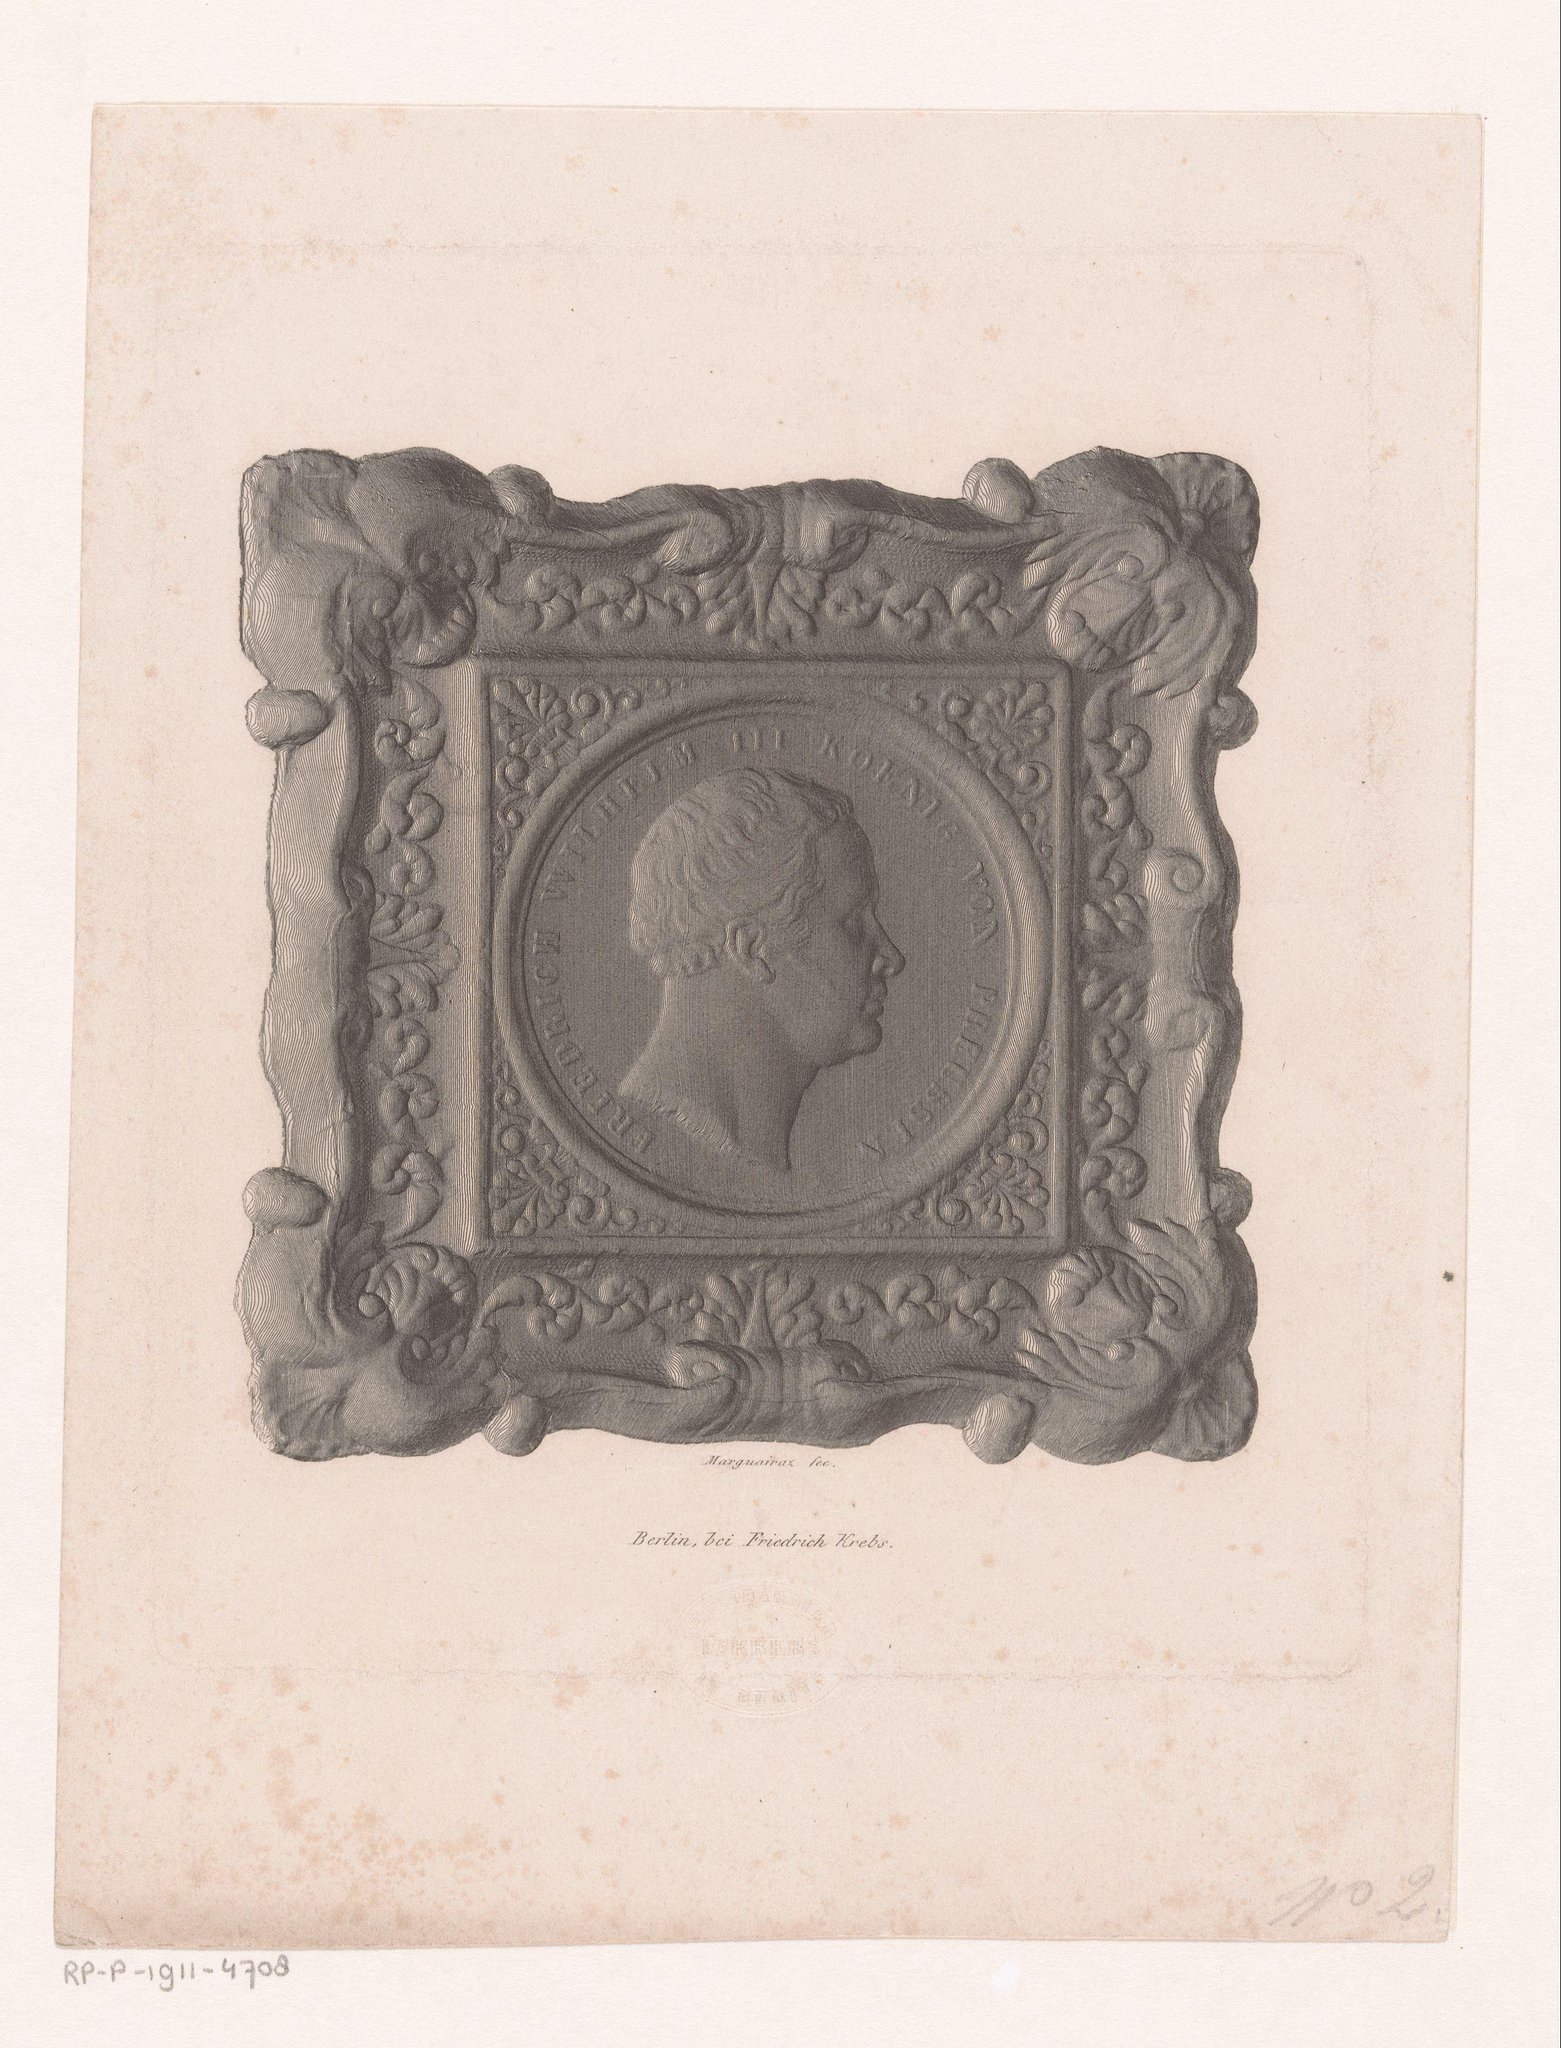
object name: print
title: Reliëf met het portret van Frederik Willem III van Pruisen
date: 1750-1849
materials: paper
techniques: etching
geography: berlin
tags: berlin, frederik willem iii koning van pruisen, historical persons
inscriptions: collector's mark: Lugt 2228